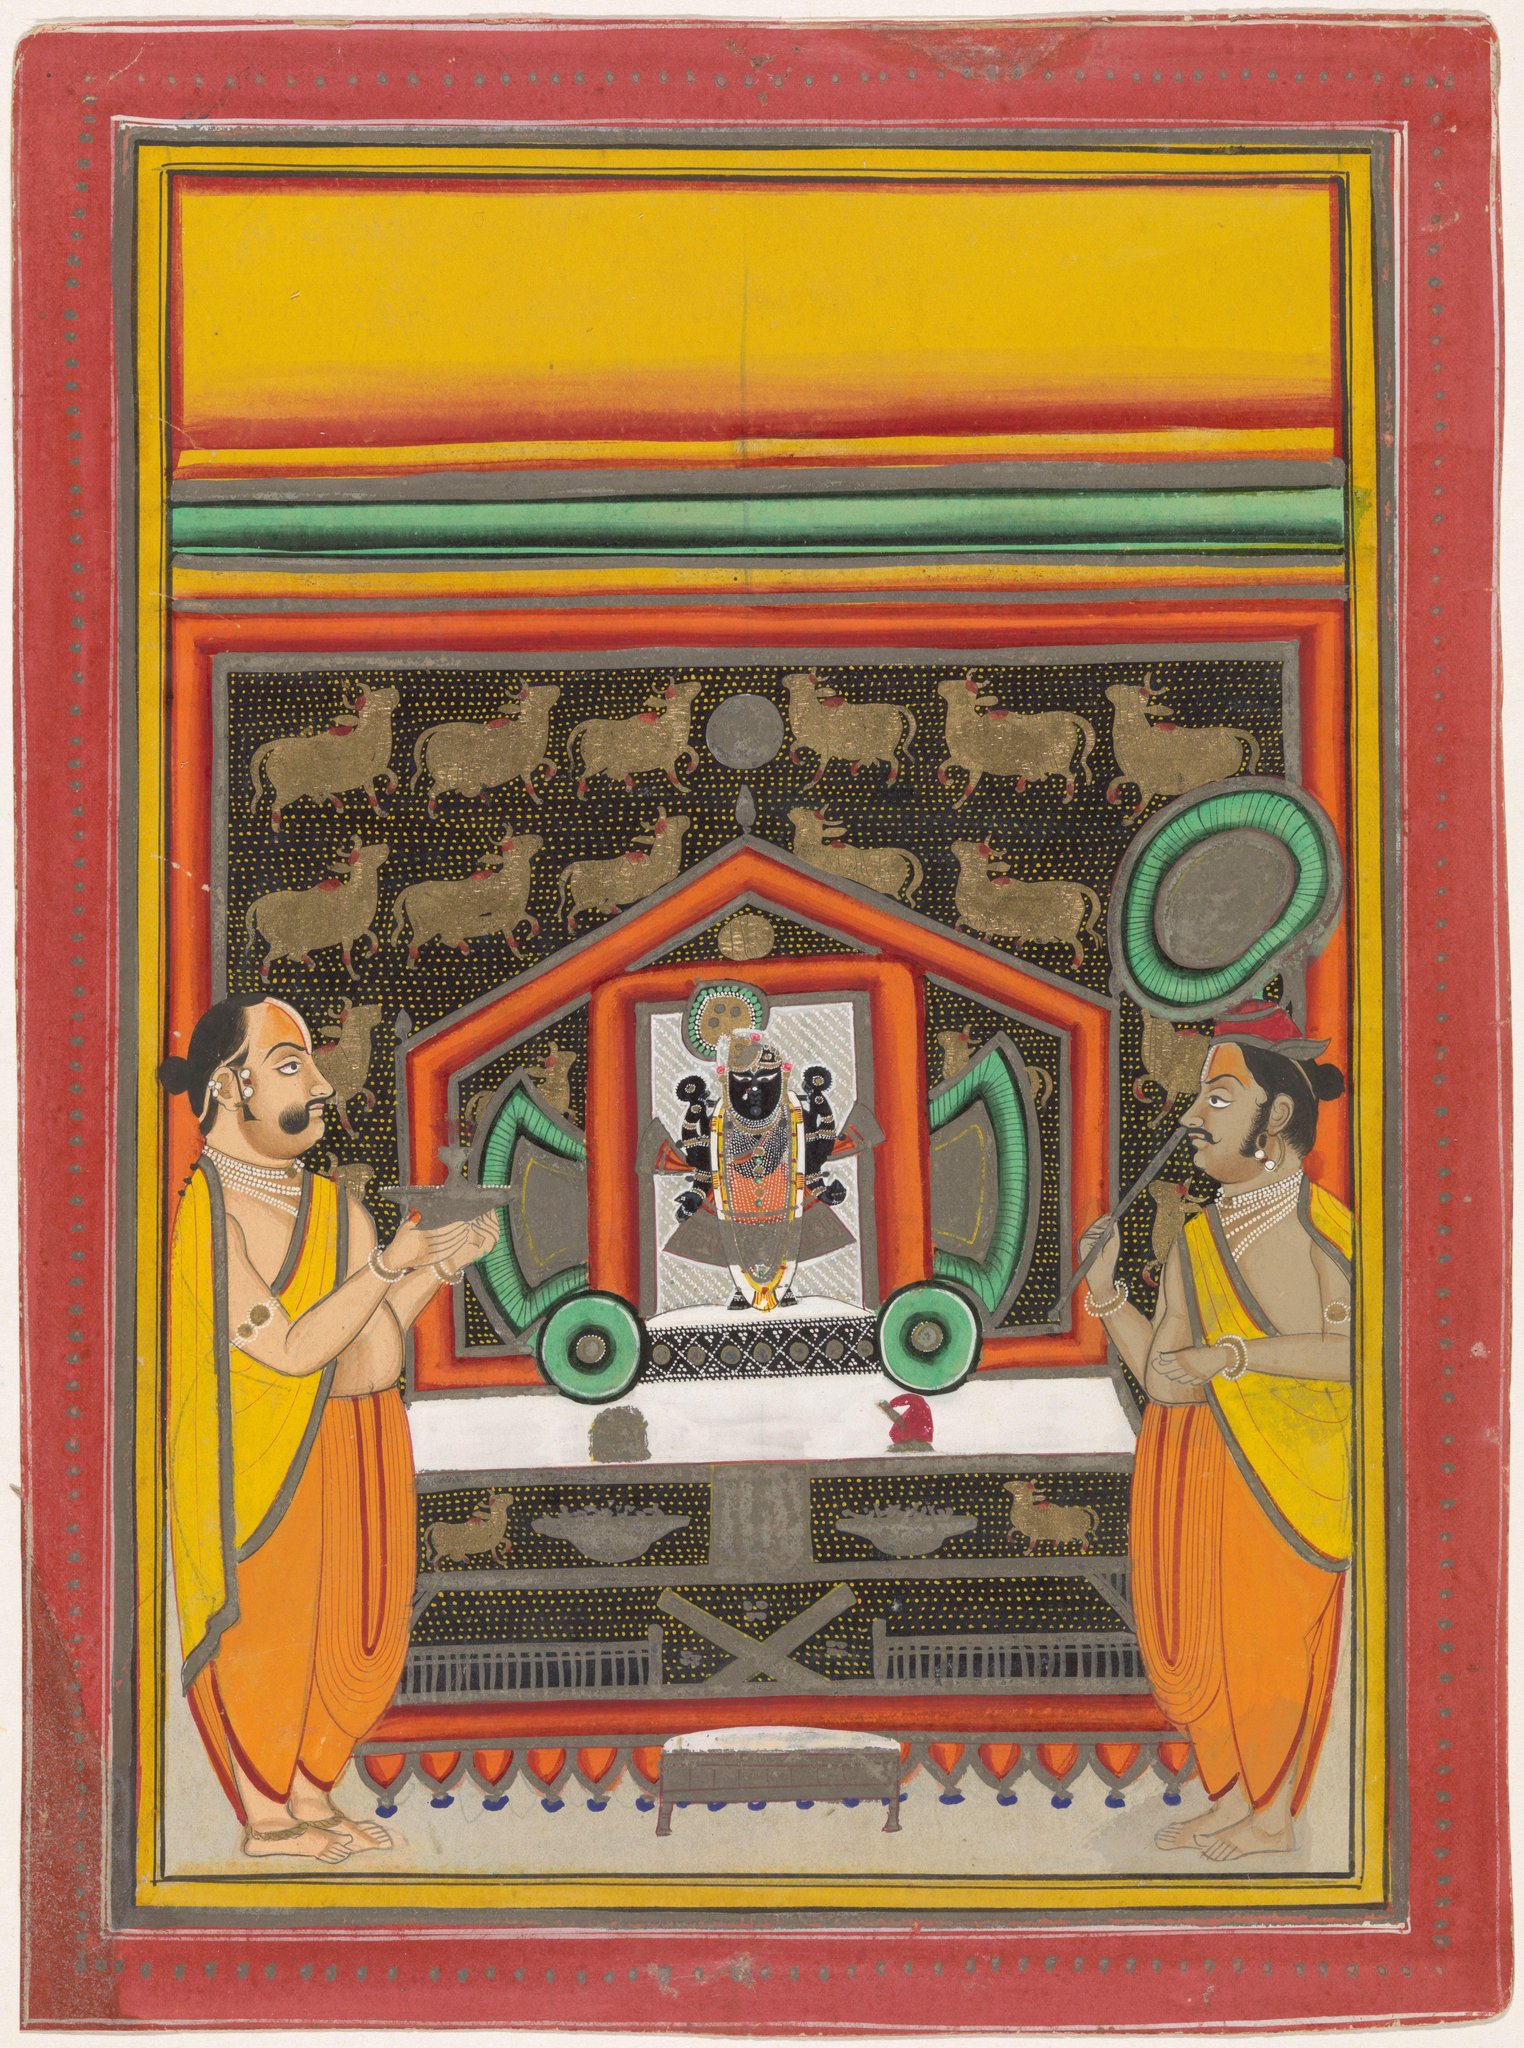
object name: indian miniature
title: Shri Nath-Ji, met koeien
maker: Anonymous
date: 1700-1949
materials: paper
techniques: brush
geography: nathdwara